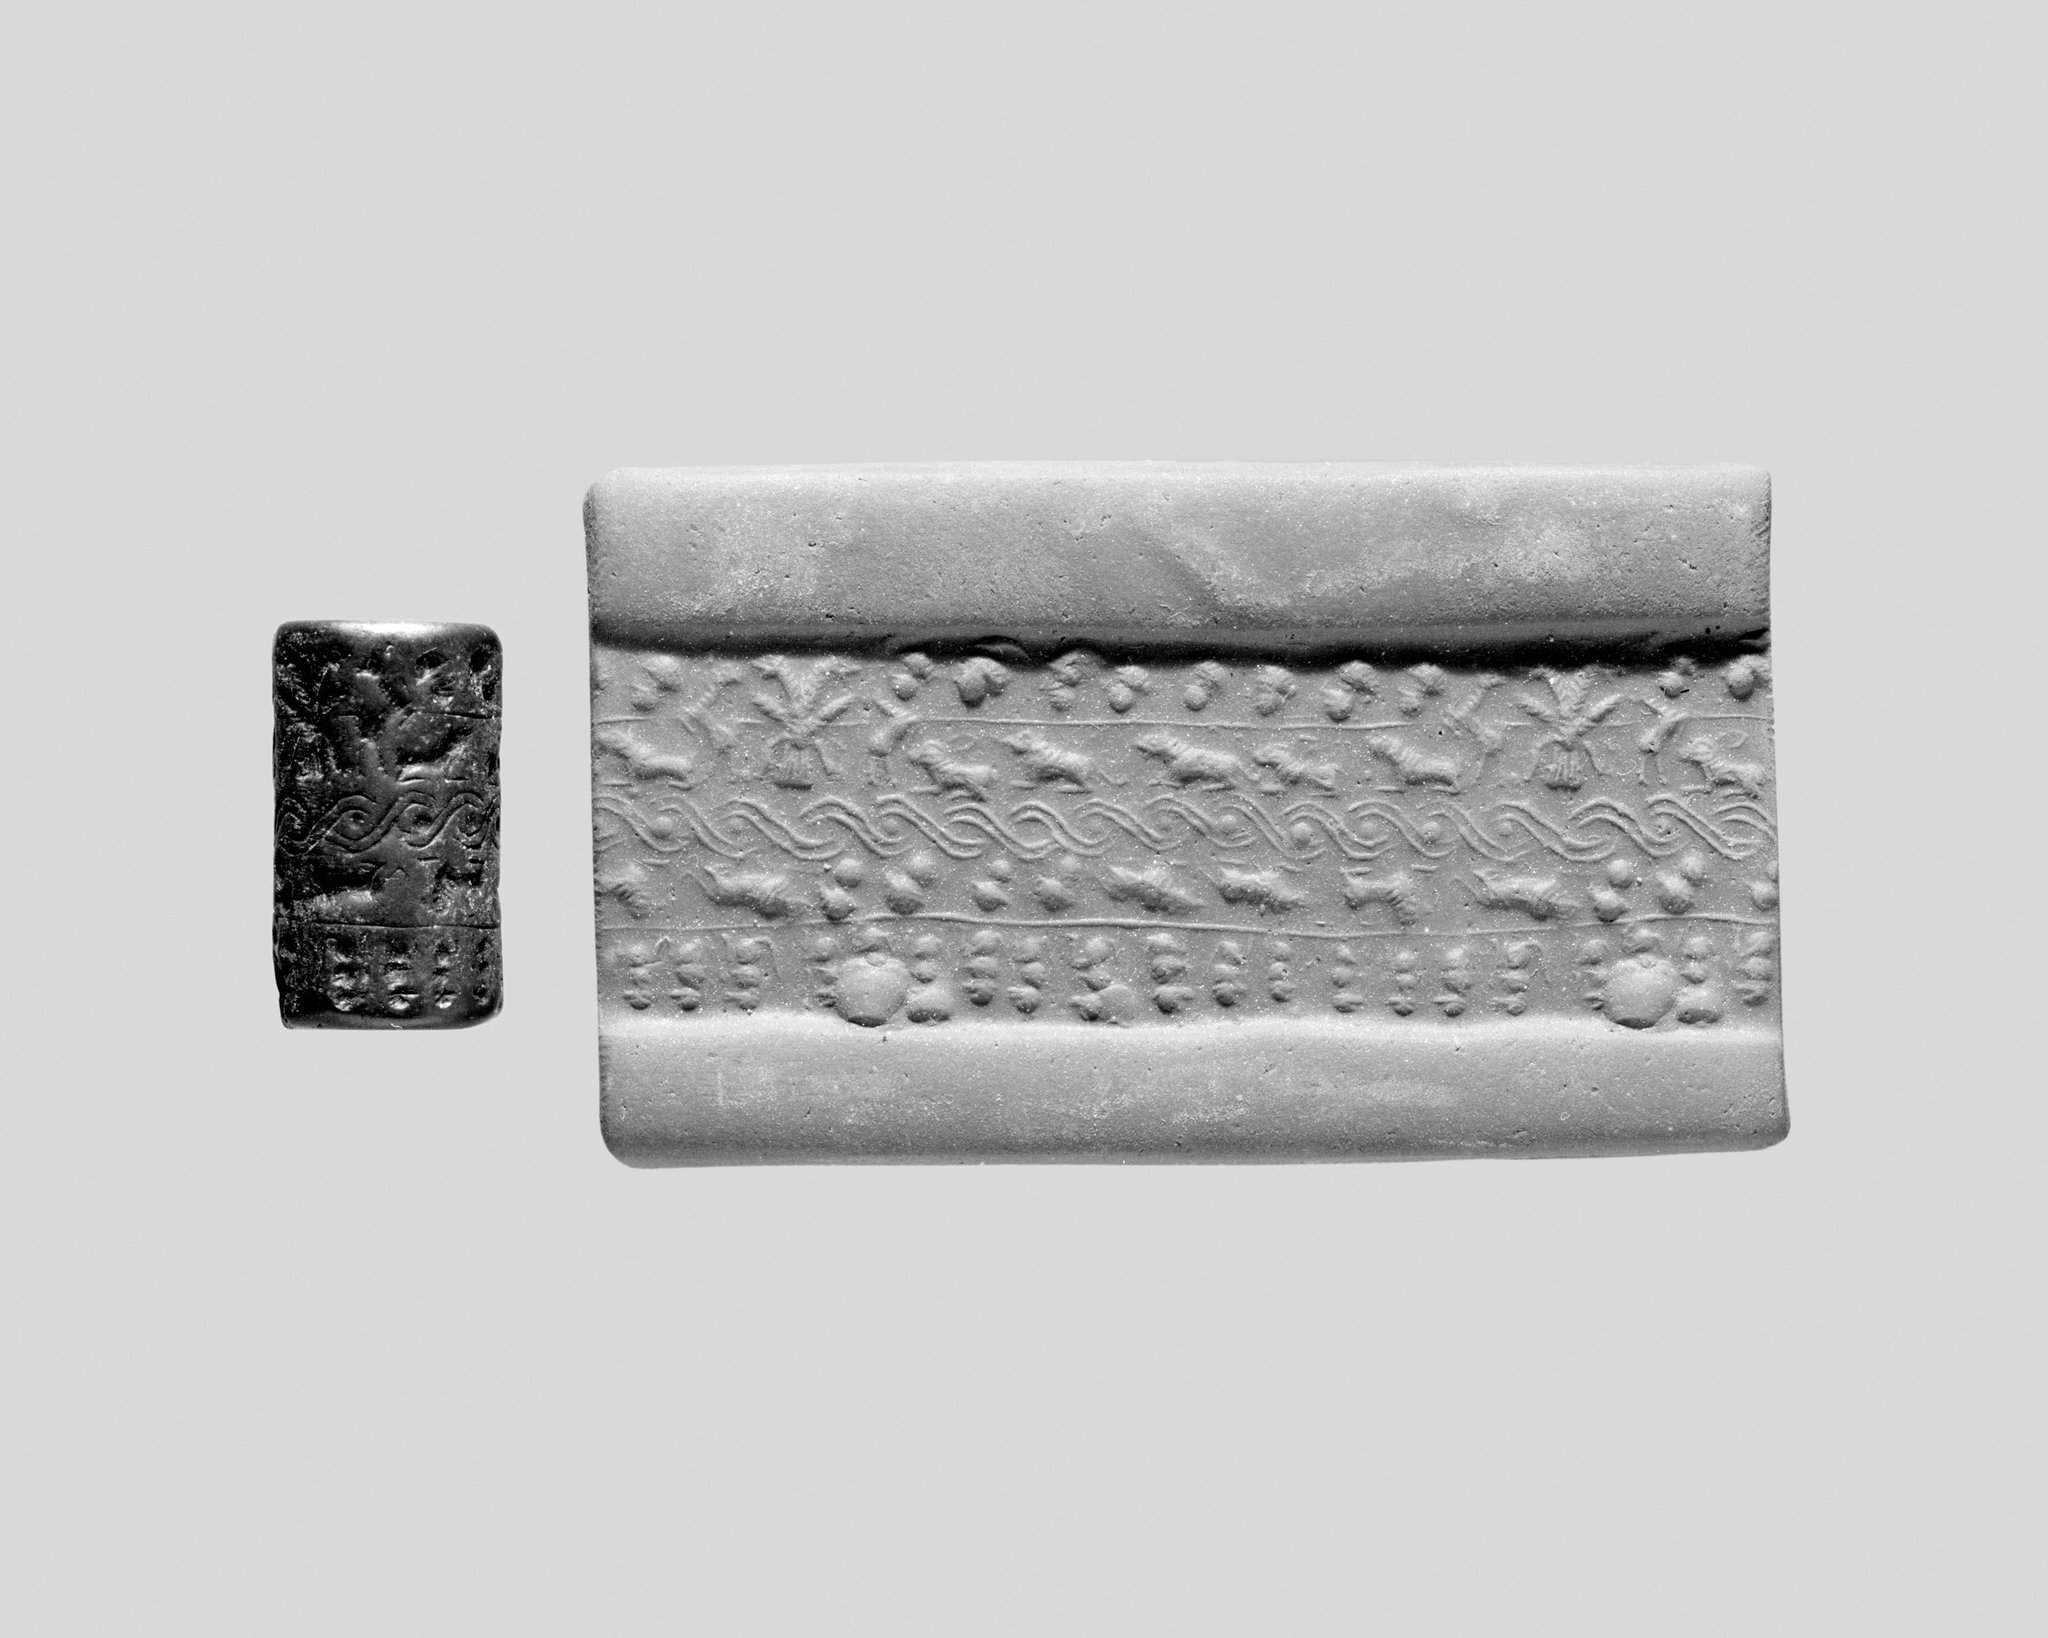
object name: cylinder seal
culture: syrian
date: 1900-1601 BCE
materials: stone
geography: syria